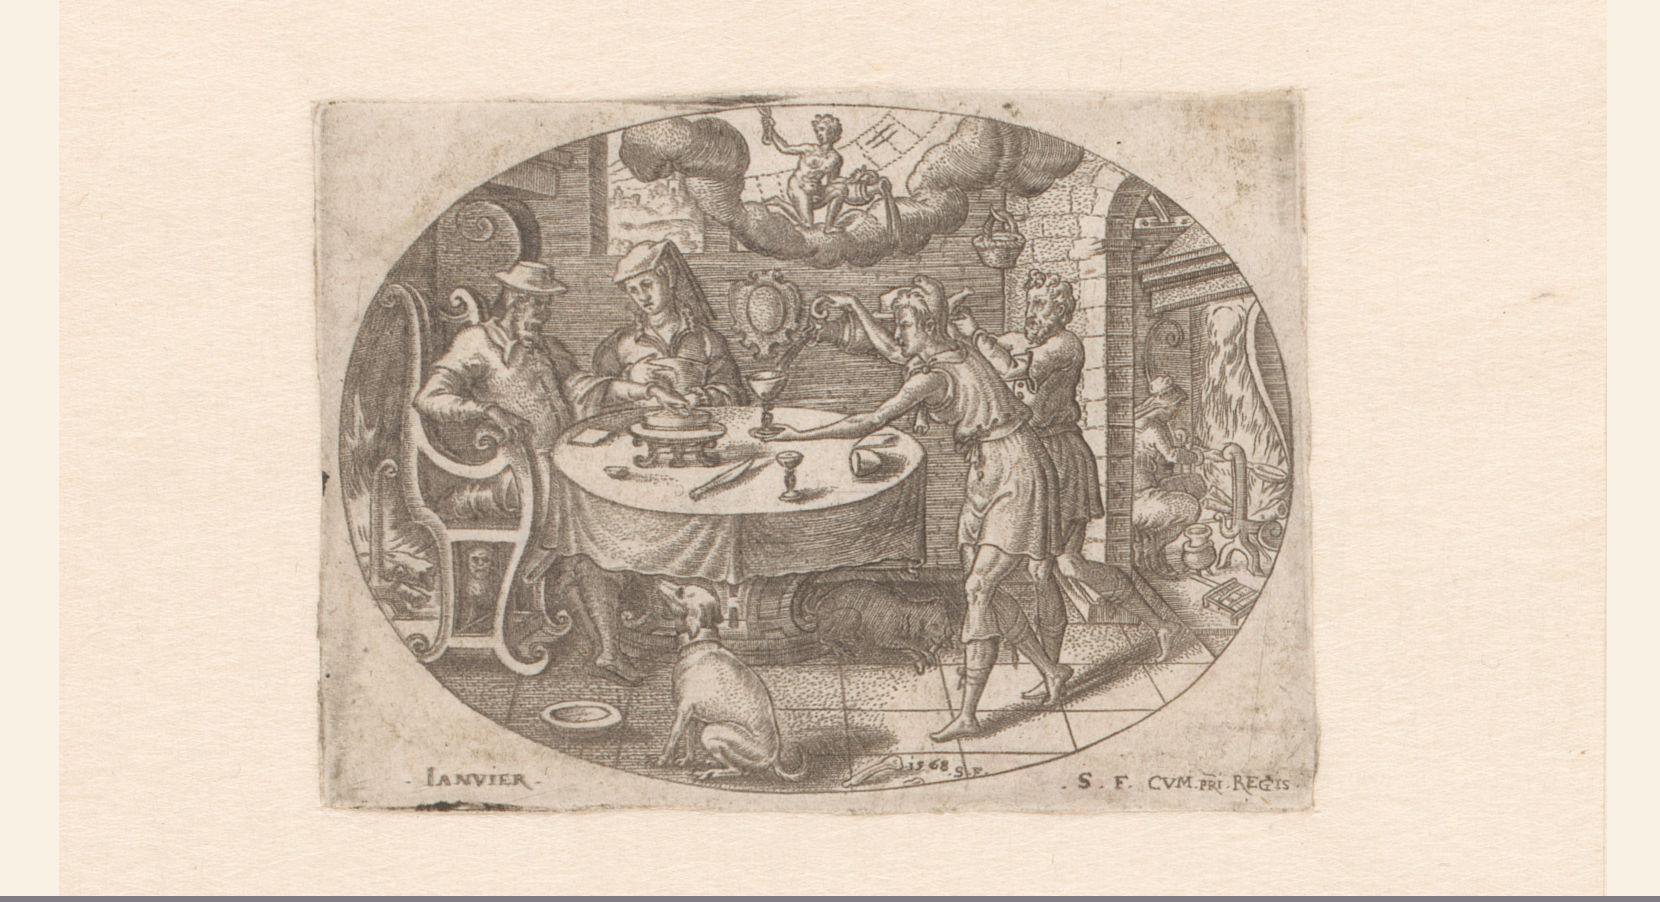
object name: print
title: Twaalf maanden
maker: etienne delaune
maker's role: draughtsman, goldsmith, print maker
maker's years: 1519-1583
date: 1568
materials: paper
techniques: engraving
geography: france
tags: aries (zodical sign of march), march and its 'labours' (+ with zodiacal signs)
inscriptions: collector's mark: Lugt 240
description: Maakt deel uit van een twaalfdelige serie van de twaalf maanden met tekens van de dierenriem, in ovale vorm. In de collectie van het Rijksmuseum bevindt zich de complete serie.